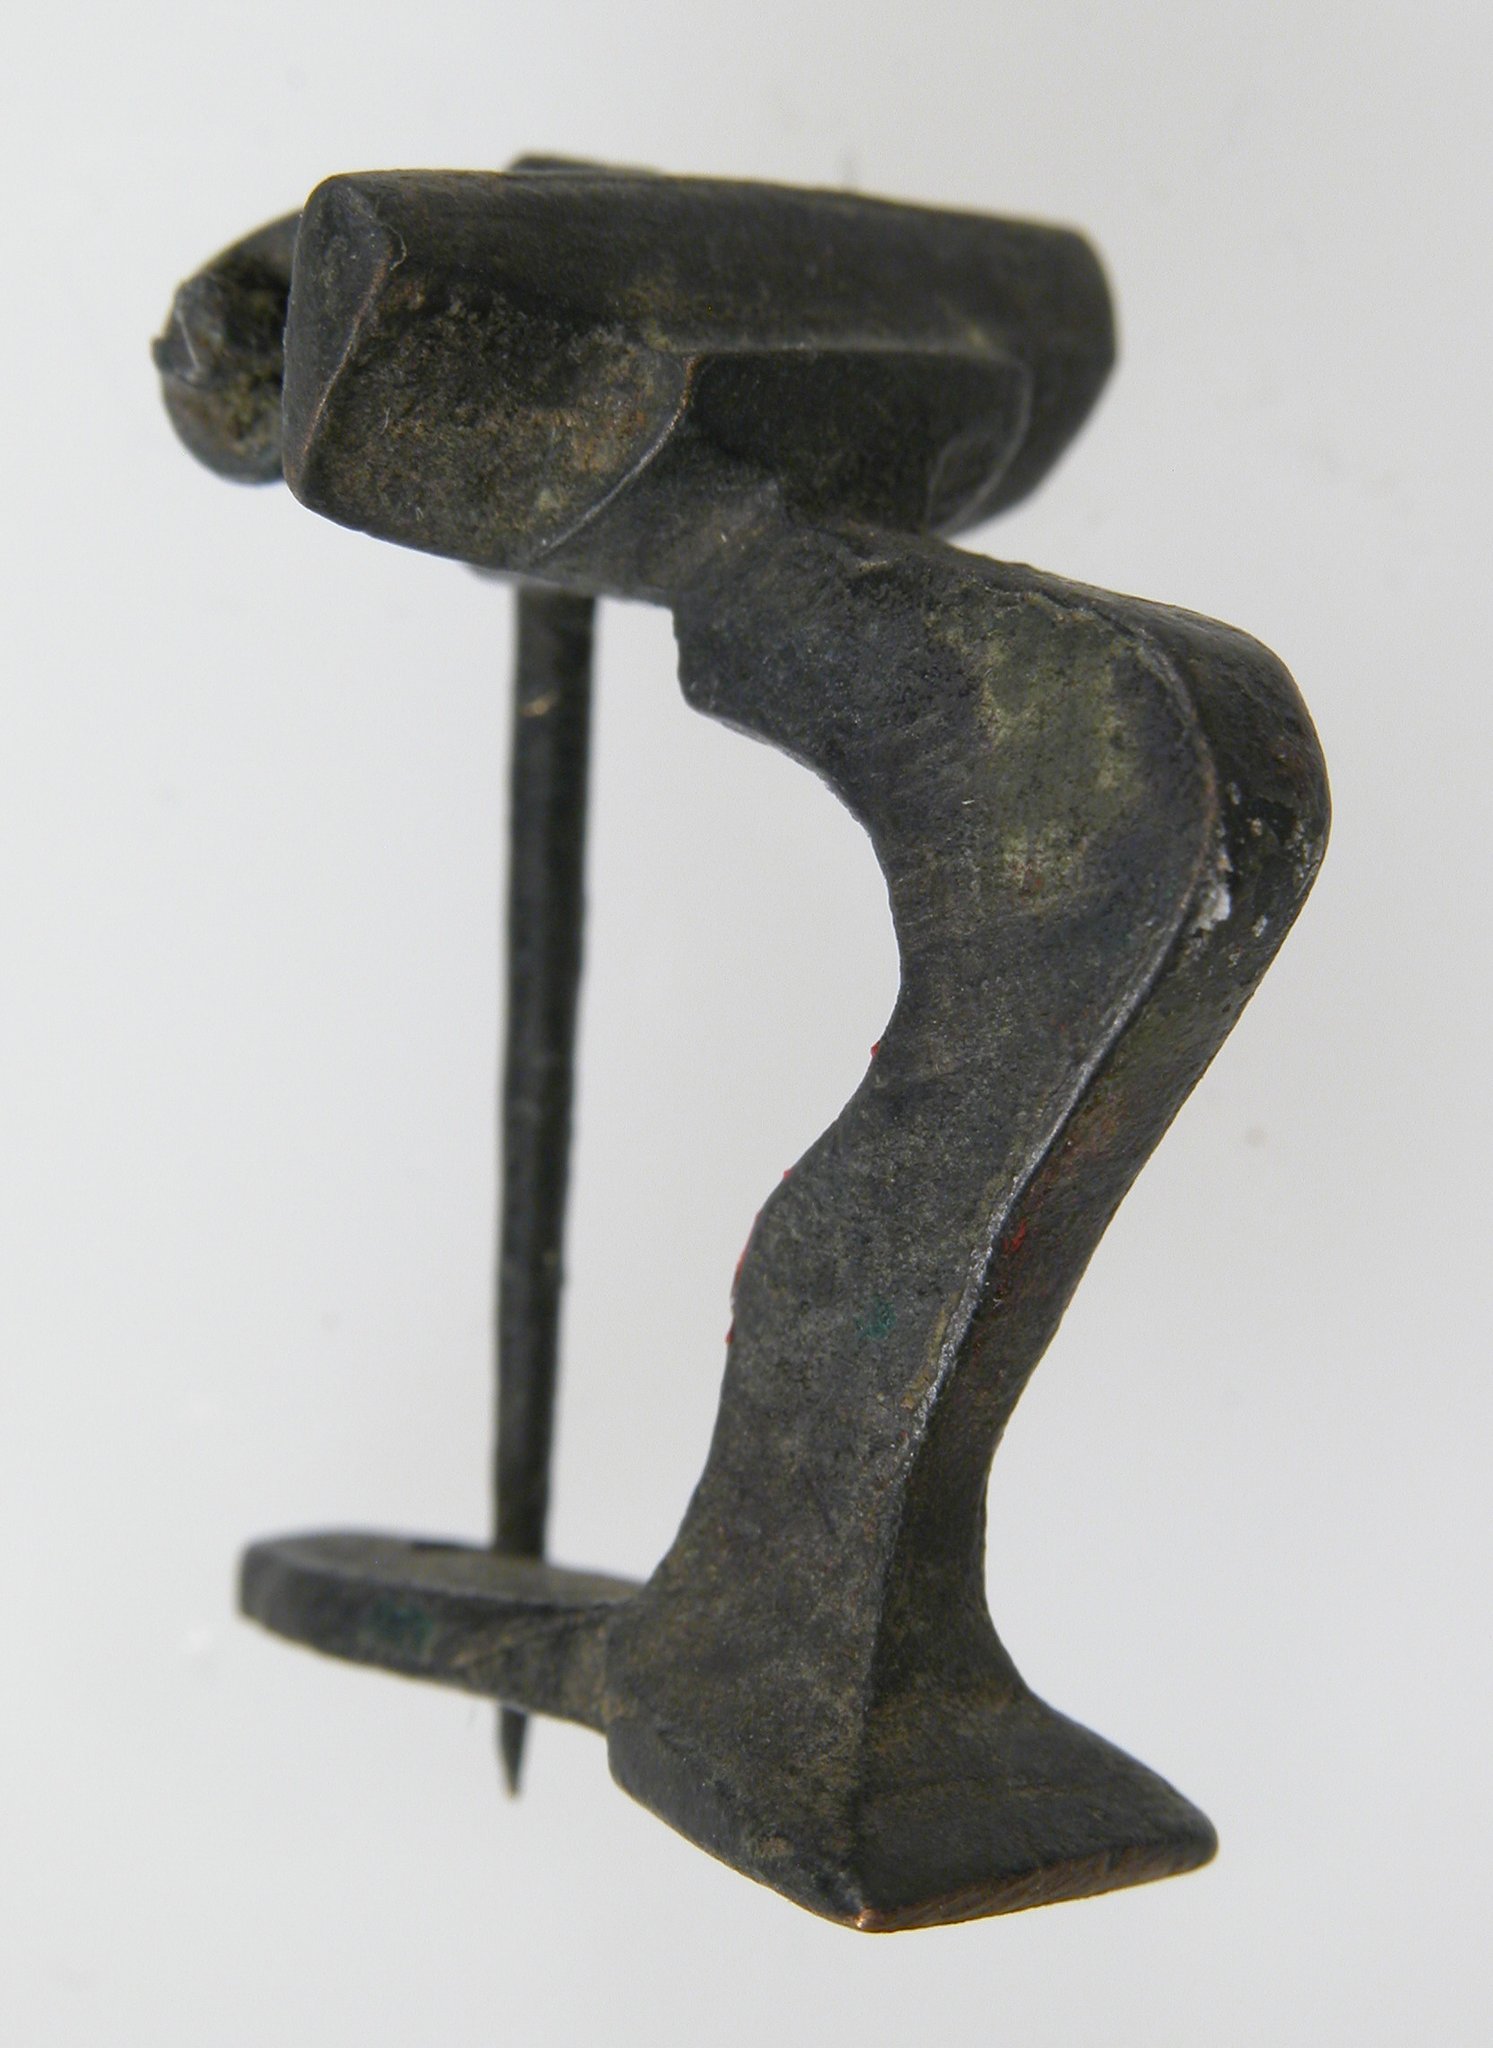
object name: brooch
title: Knee Brooch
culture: roman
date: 101-200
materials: copper alloy